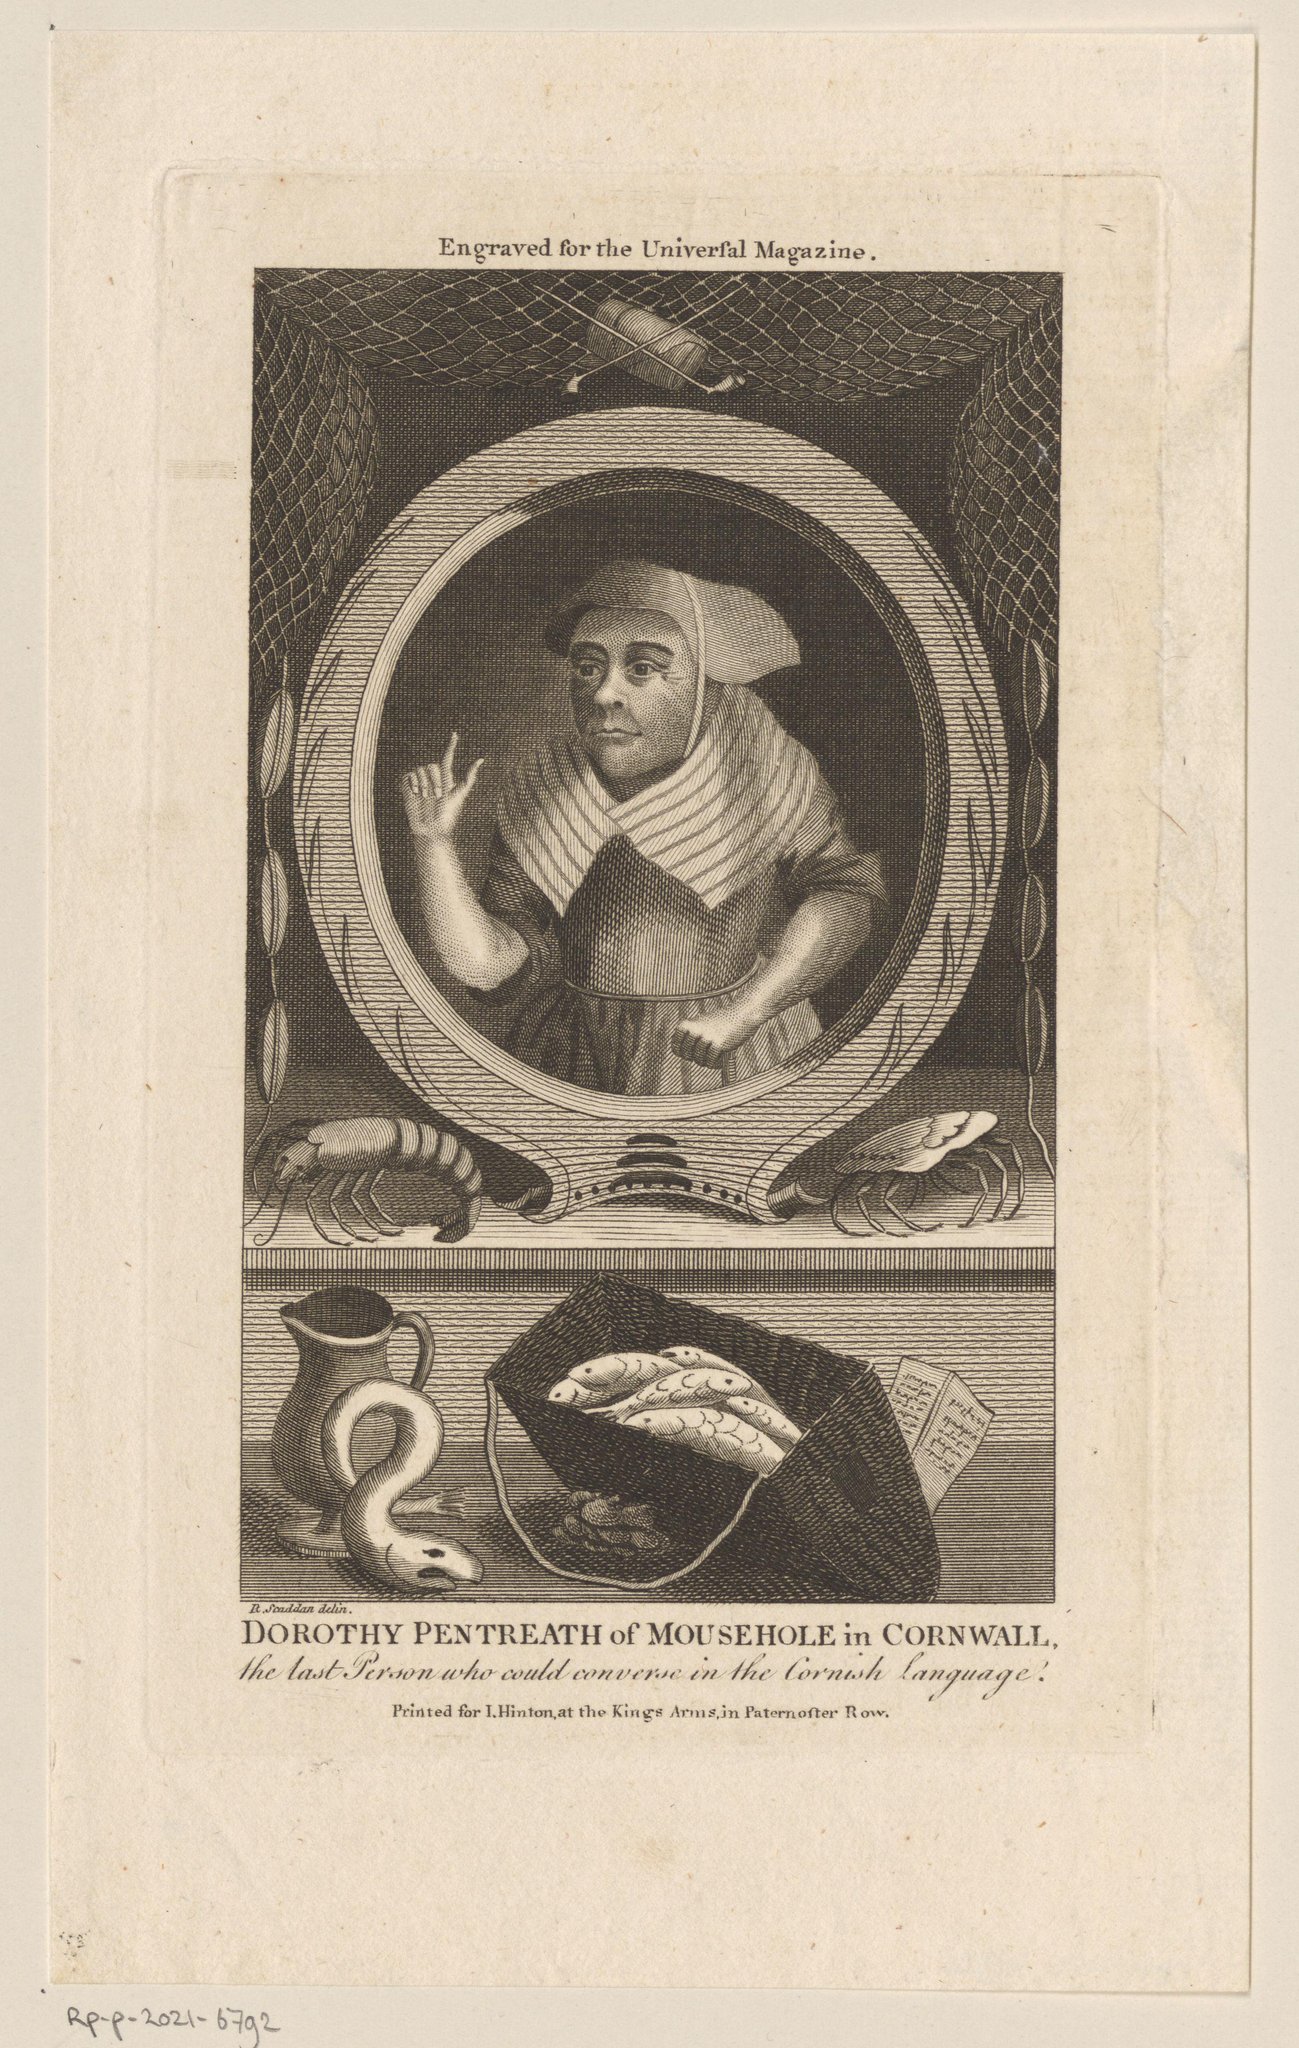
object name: print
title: Portret van Dorothy Pentreath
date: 1701-1781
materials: paper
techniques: engraving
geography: london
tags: adult woman, animals, historical persons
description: Prent uit: The Universal Magazine of Knowledge and Pleasure 68 (1781), januari 1781.